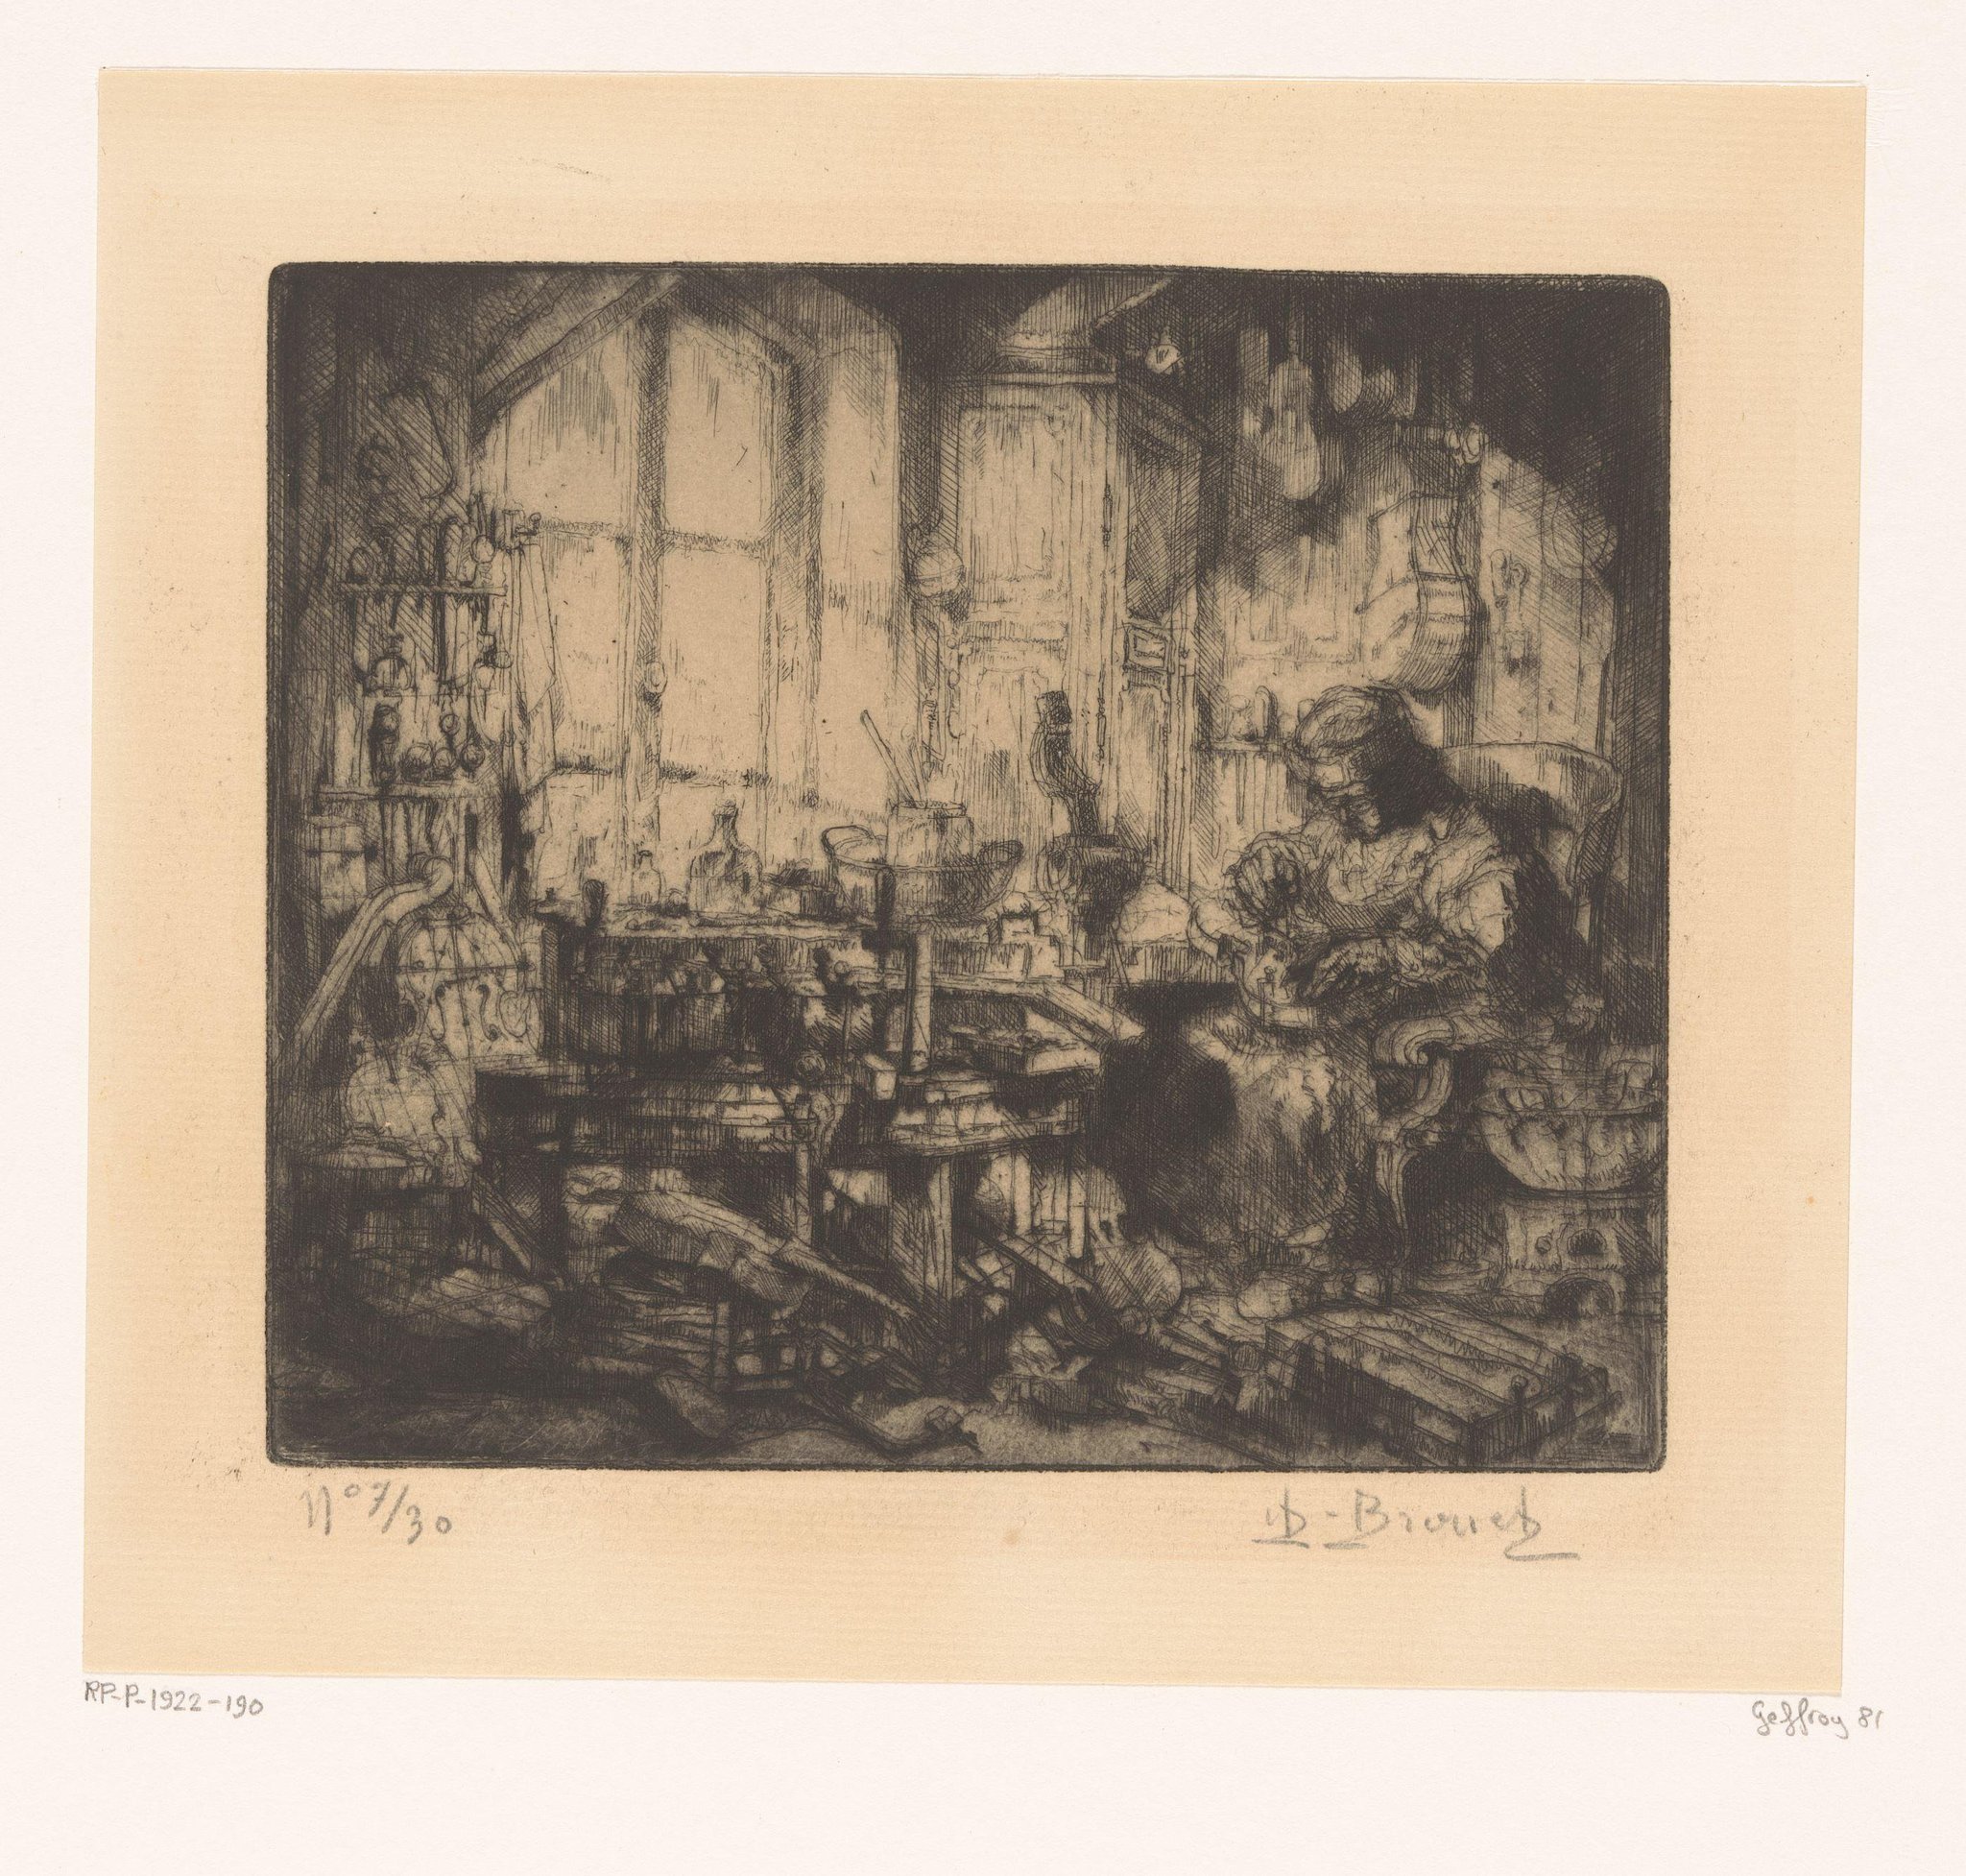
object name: print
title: Instrumentenbouwer in zijn werkplaats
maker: auguste brouet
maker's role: painter, print maker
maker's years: 1872-1941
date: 1882-1922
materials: paper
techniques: drypoint, etching, intaglio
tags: musical instruments; group of musical instruments, handicrafts, craftsman at work, workshop-interior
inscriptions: check stamp: Lugt 311b, collector's mark: Lugt 2228